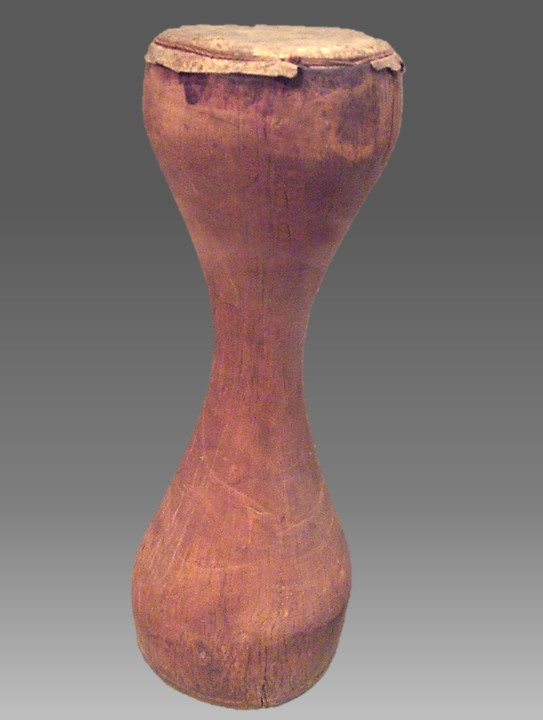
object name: aje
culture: micronesian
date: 1867-1900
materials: cord, skin, wood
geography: marshall islands